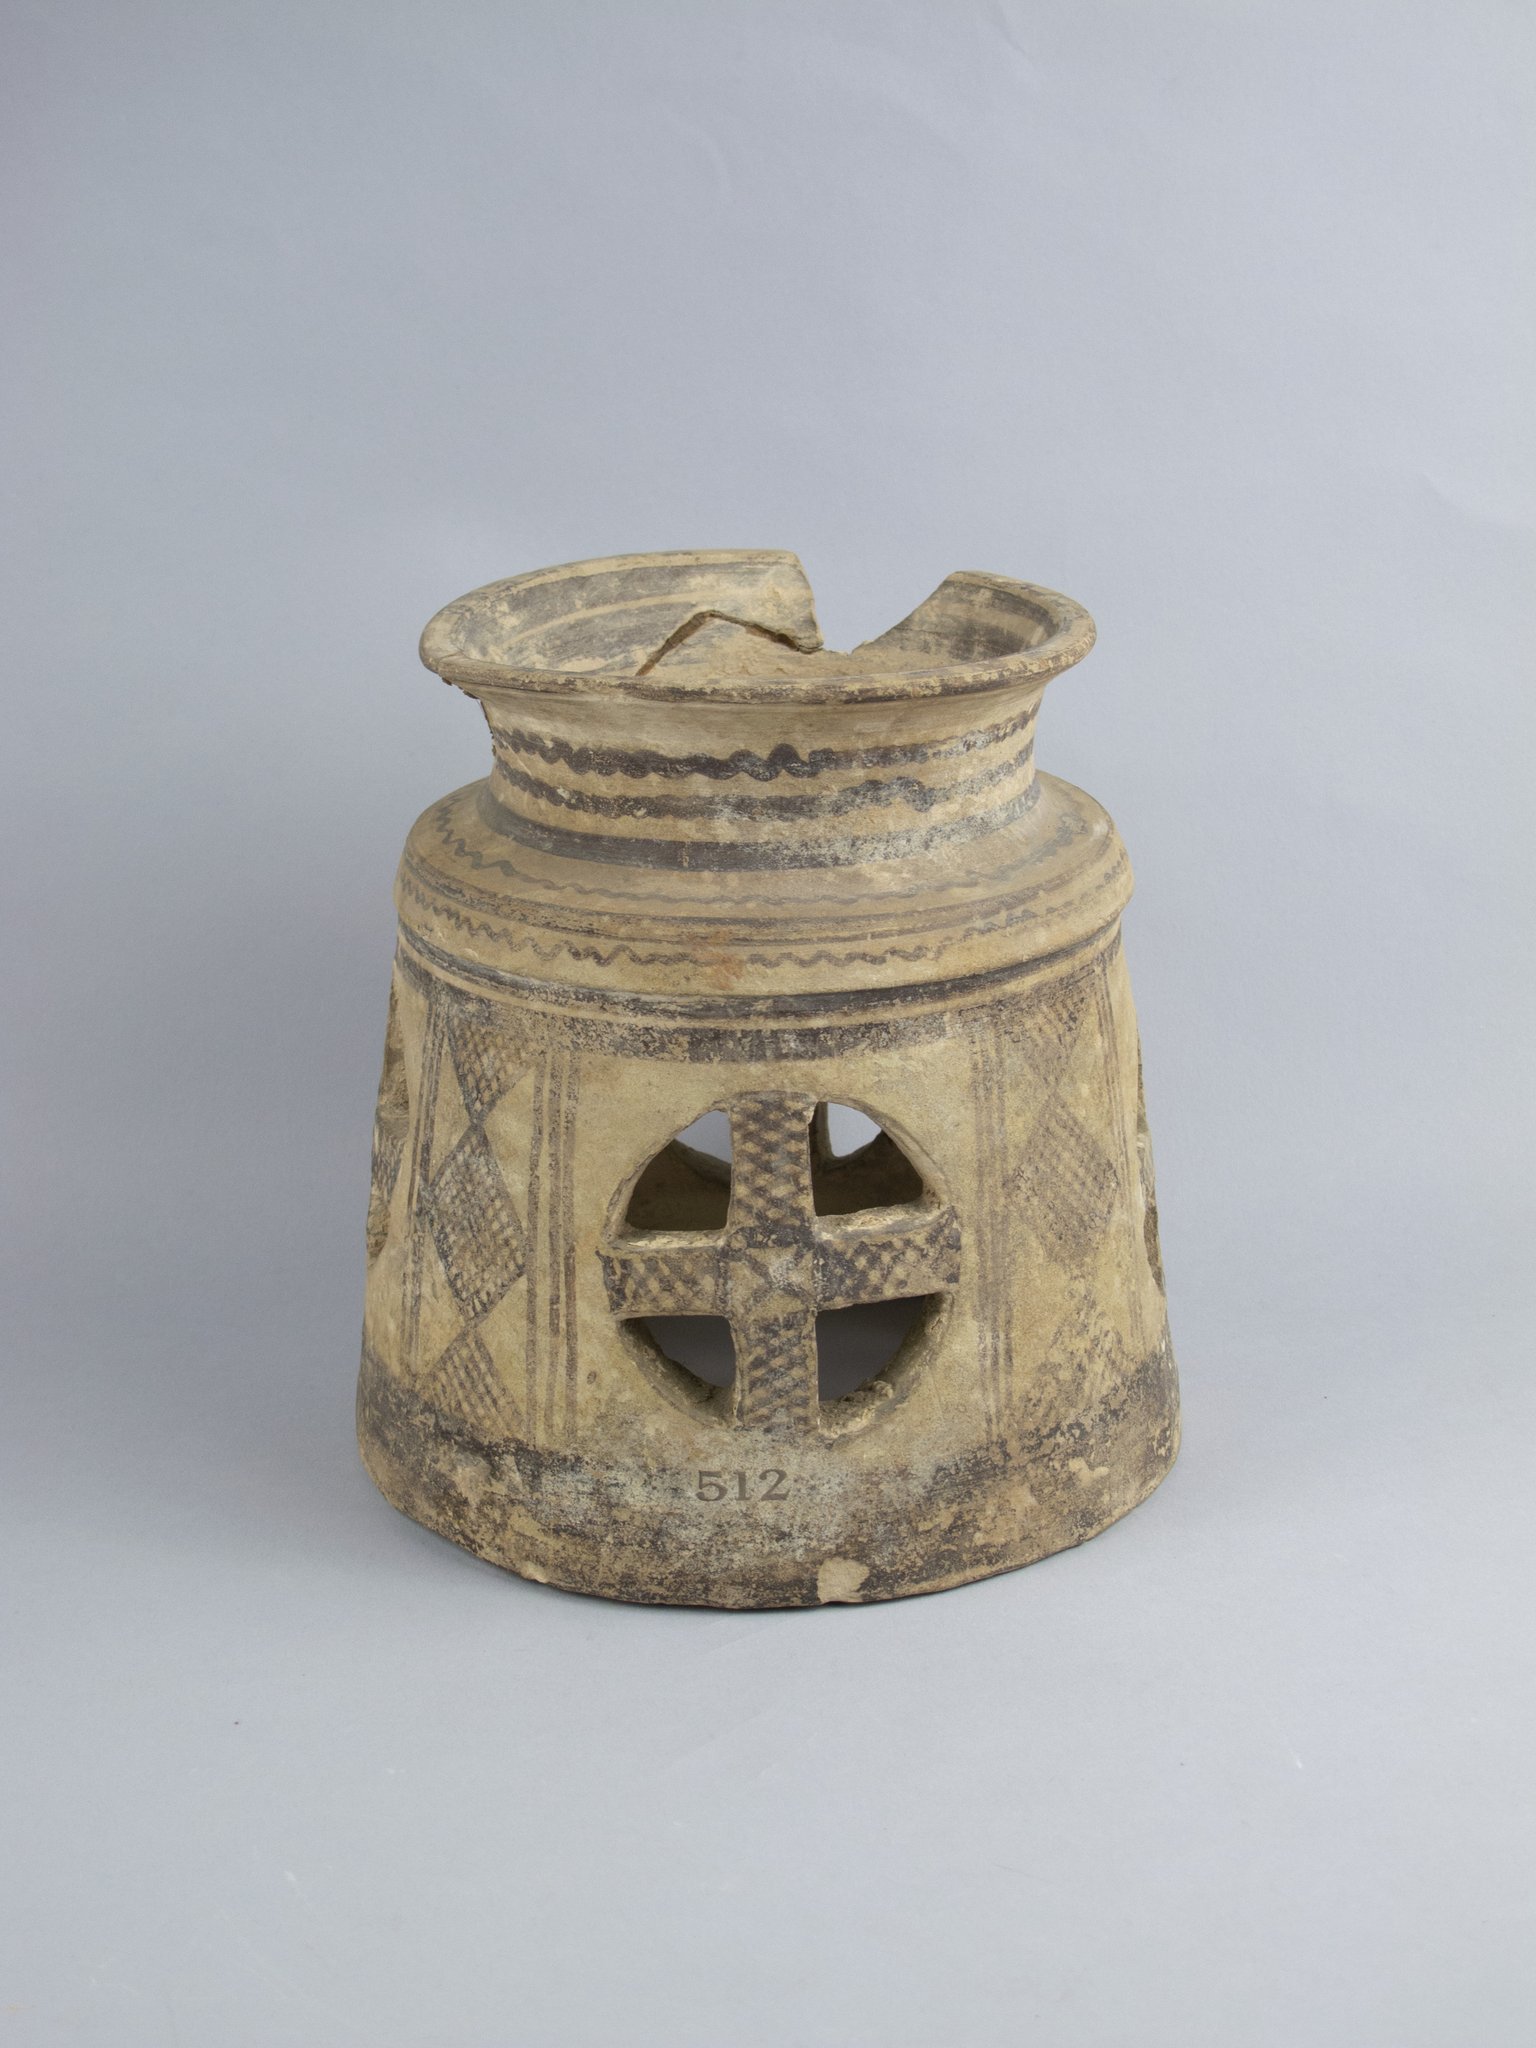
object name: tripod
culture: cypriot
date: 1050-950 BCE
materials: terracotta